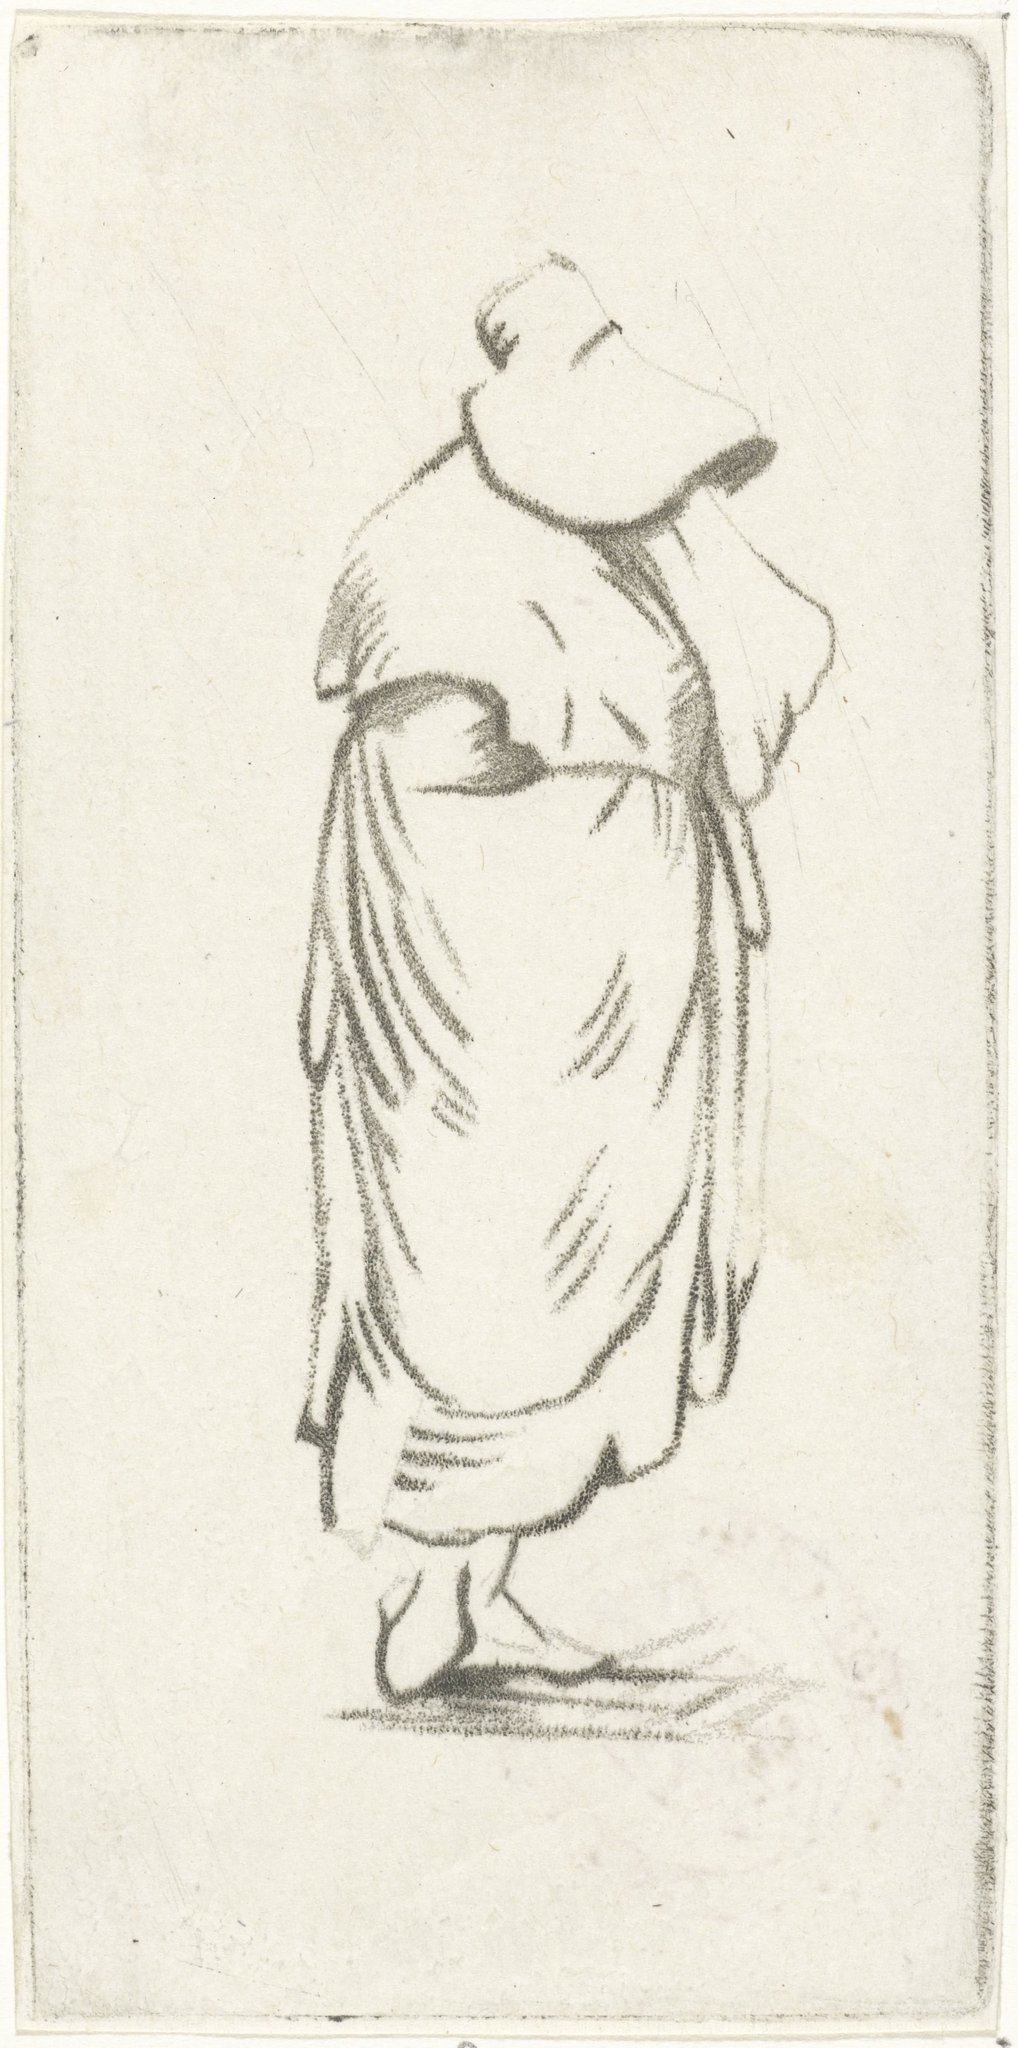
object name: print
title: Staande vrouw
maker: cornelis ploos van amstel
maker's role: draughtsman, print maker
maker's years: 1726-1798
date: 1736-1798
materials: paper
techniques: printmaking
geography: amsterdam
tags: adult woman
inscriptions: collector's mark: Lugt 240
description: Staande vrouw, die een zakdoek tegen haar gezicht houdt.